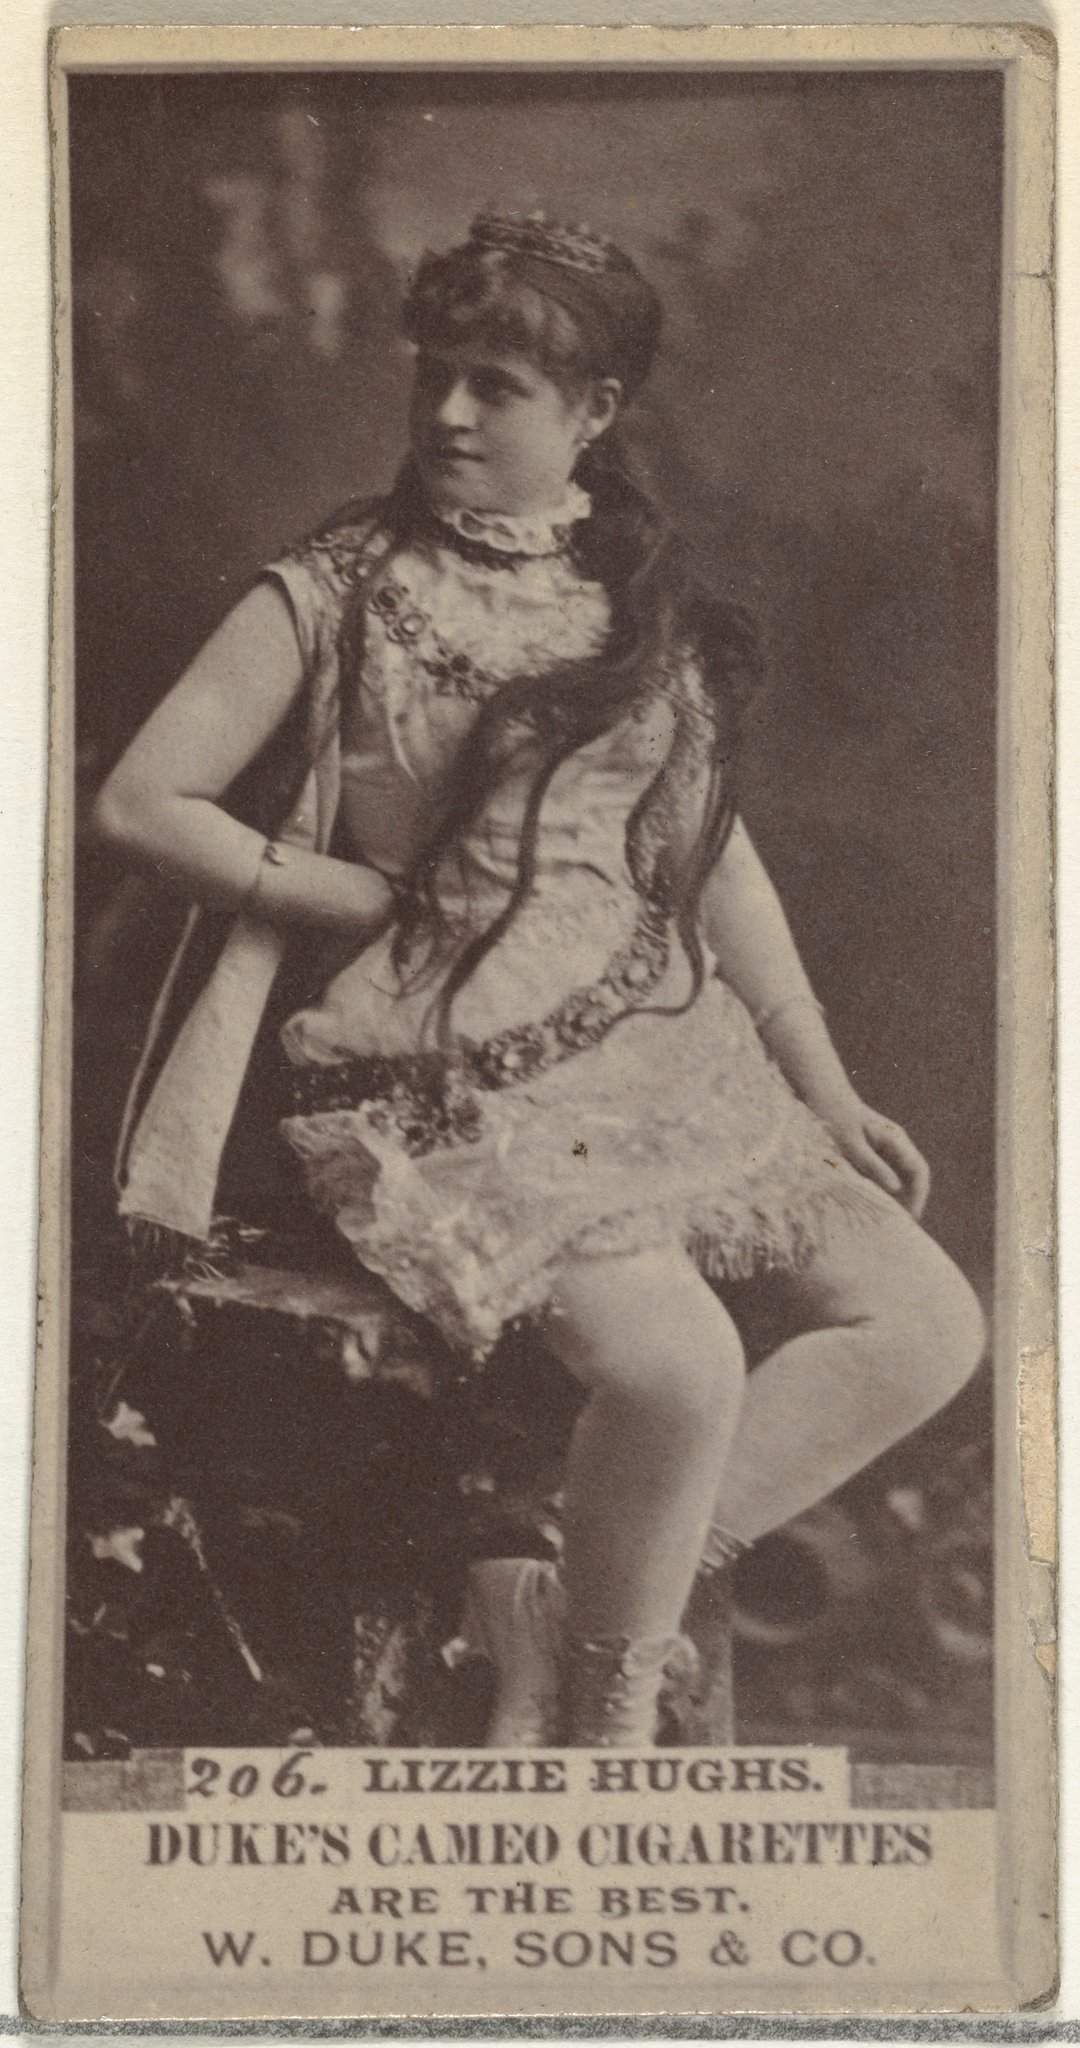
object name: photograph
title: Card Number 206, Lizzie Hughs, from the Actors and Actresses series (N145-5) issued by Duke Sons & Co. to promote Cameo Cigarettes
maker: w. duke, sons & co.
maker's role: publisher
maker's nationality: american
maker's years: 1870-1920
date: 1880-1889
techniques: albumen silver print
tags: portraits,women,actresses